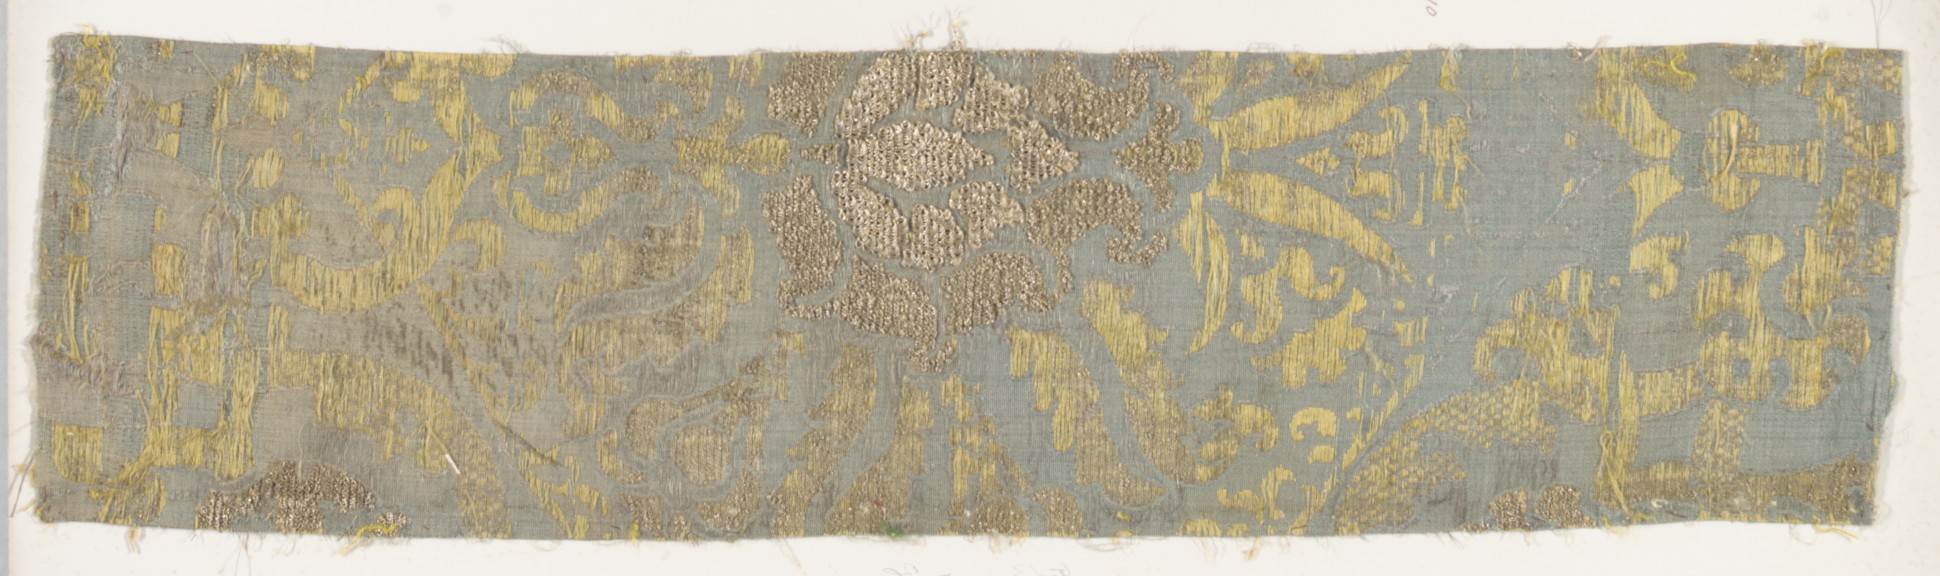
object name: fragment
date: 1501-1533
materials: metal thread, silk